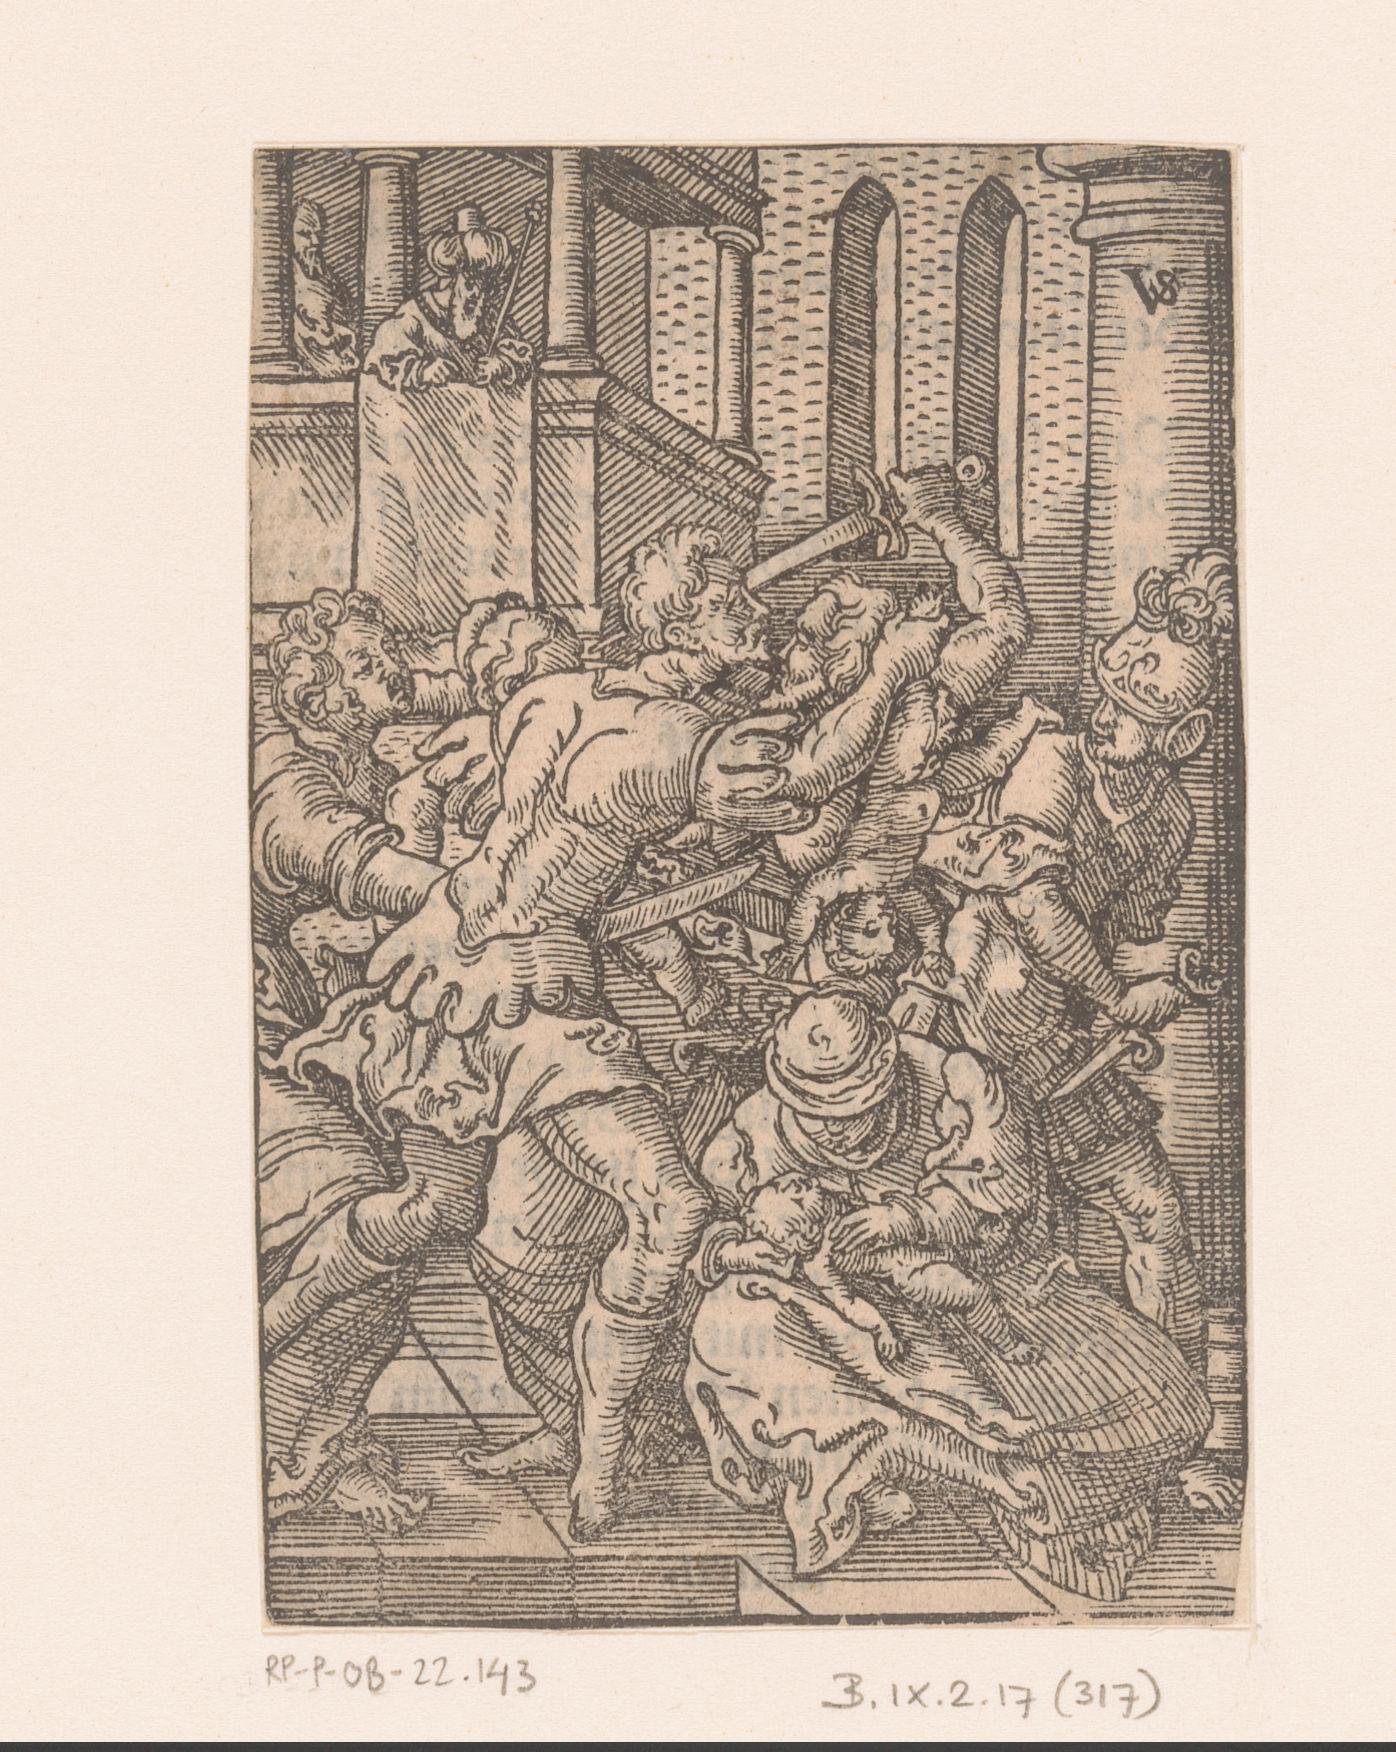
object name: print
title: Kindermoord te Betlehem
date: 1552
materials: paper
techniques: woodcut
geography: nuremberg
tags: the massacre ot the innocents; sometimes herod looking on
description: Gebruikt voor verschillende publicaties die werden gedrukt door Valentin Geißler tussen 1552 en 1560 te Neurenberg.